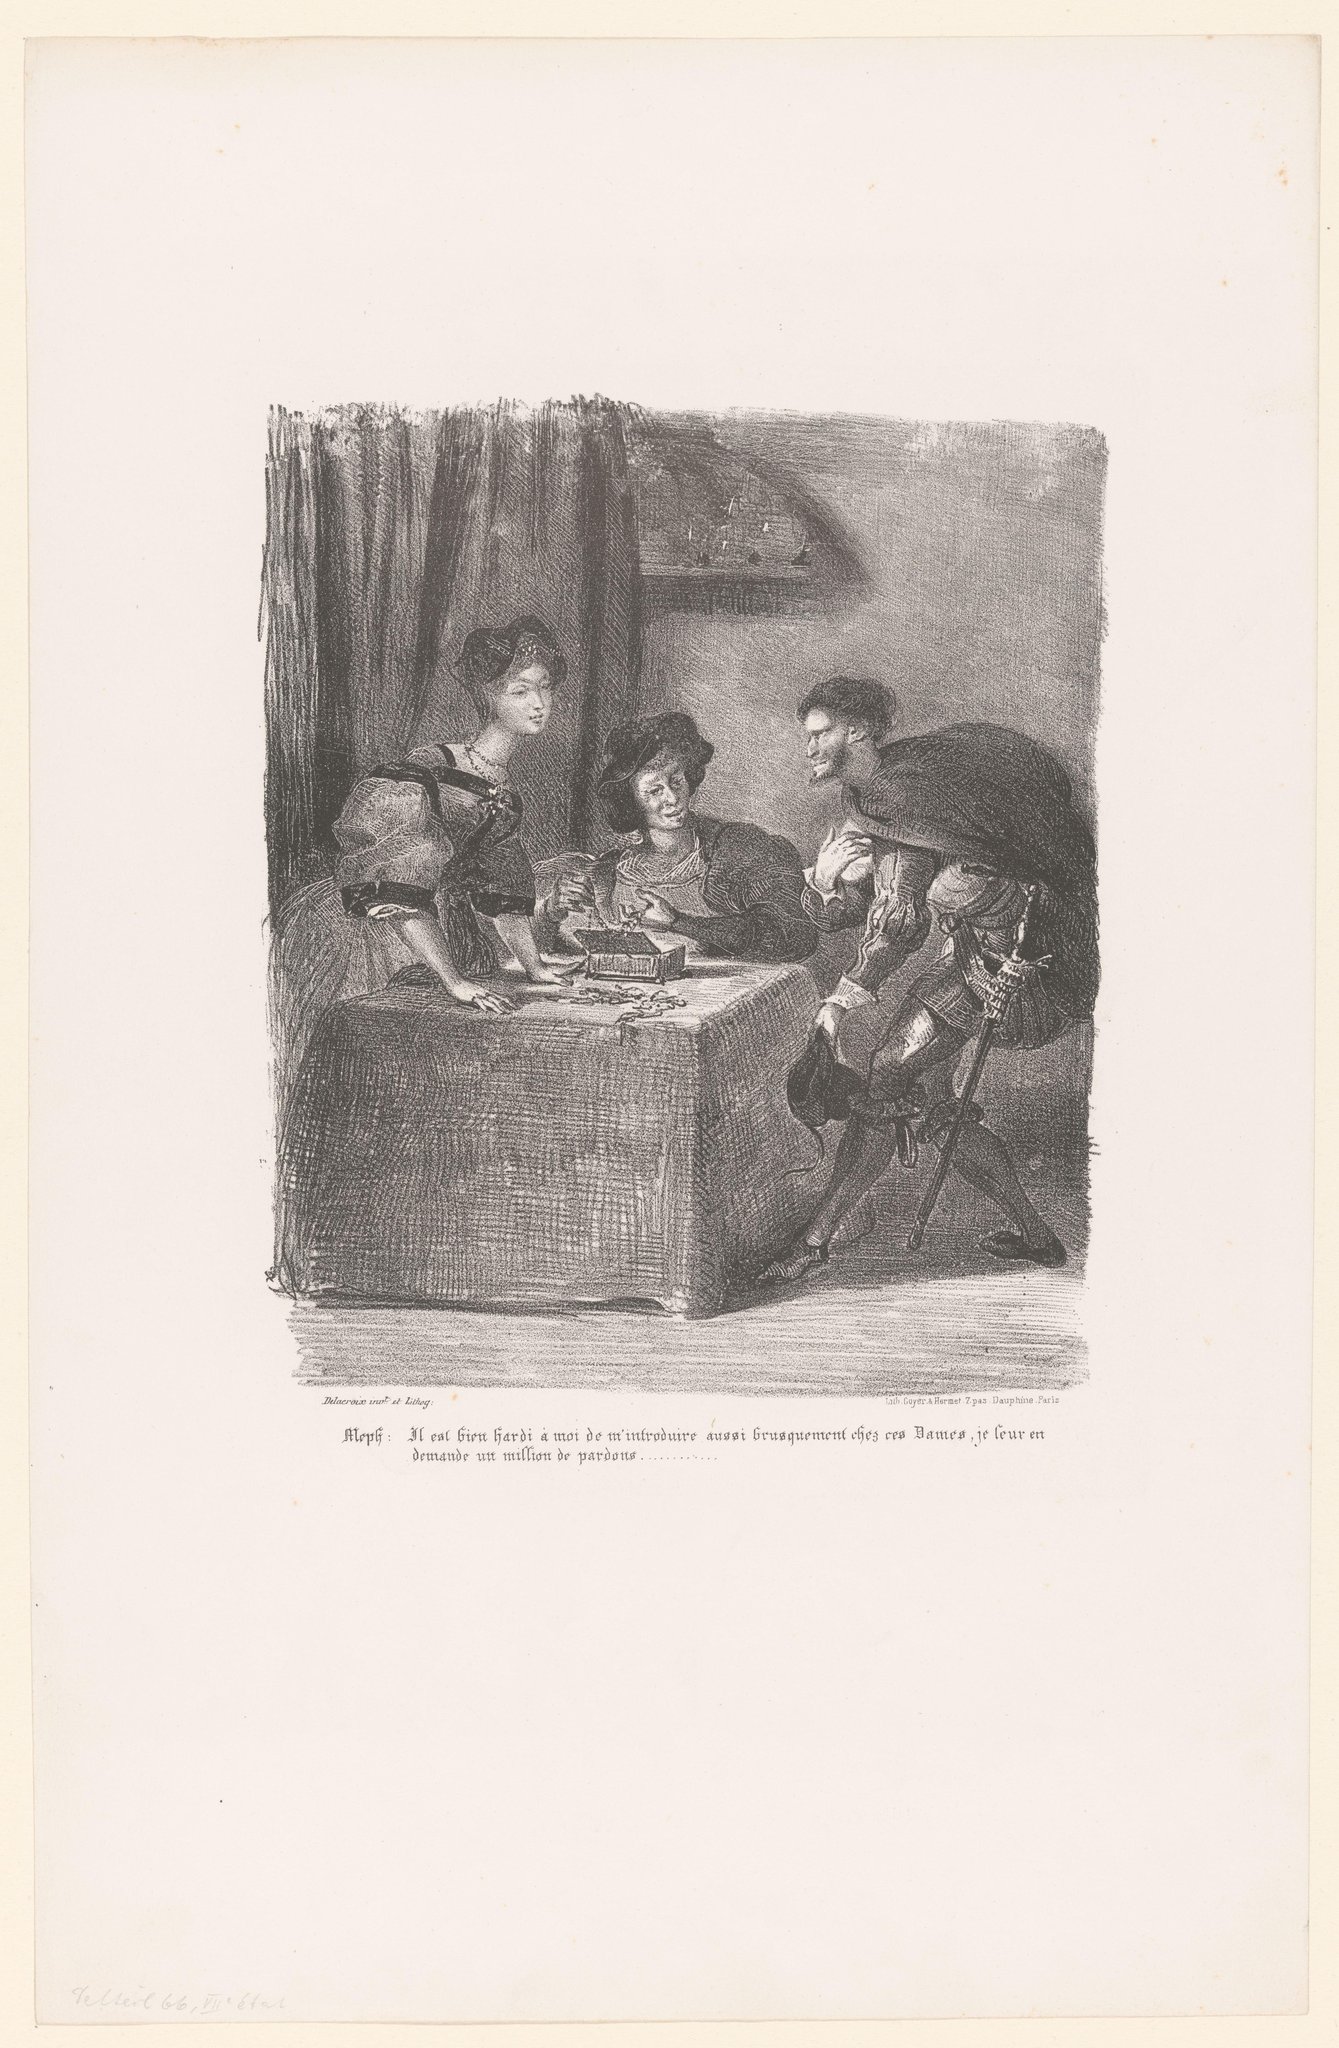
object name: print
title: Mephisto stelt zich voor aan Grietje en Marthe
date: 1828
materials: paper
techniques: lithograph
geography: paris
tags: (scenes from) specific works of literature: goethe, faust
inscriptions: collector's mark: Lugt 964, collector's mark: Lugt 2228a